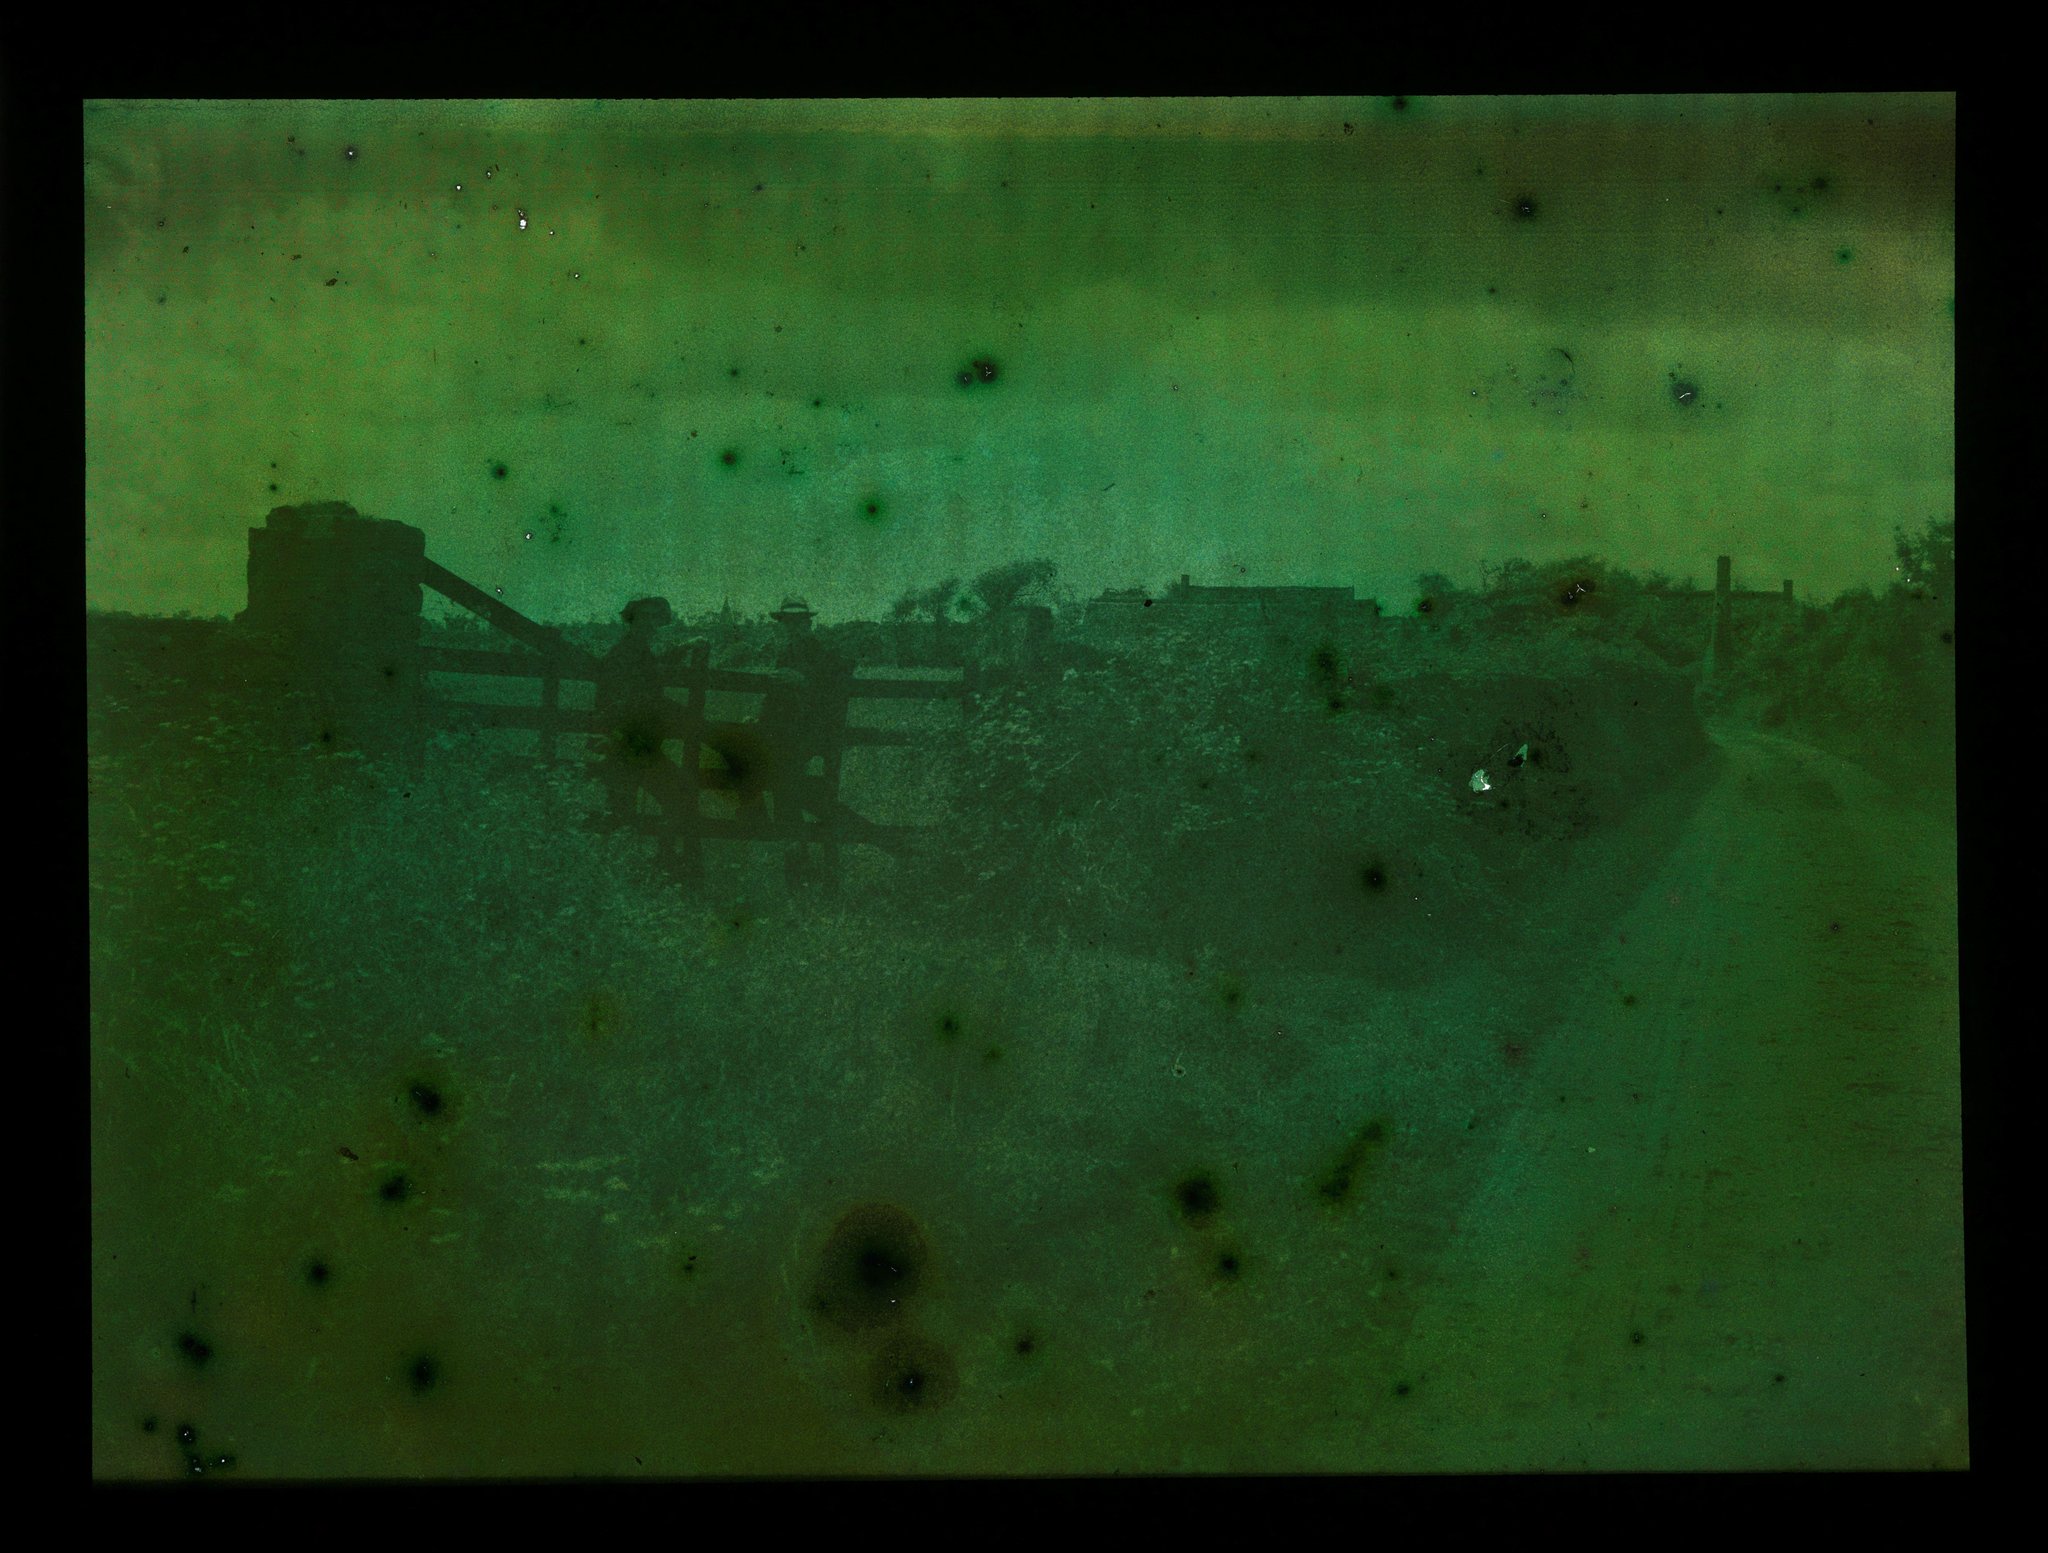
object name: photograph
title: Weg met links een hek naar een weiland, waar twee mensen tegen aan geleund staan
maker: Anonymous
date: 1910-1940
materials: glass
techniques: autochrome process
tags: fence, wall, paling